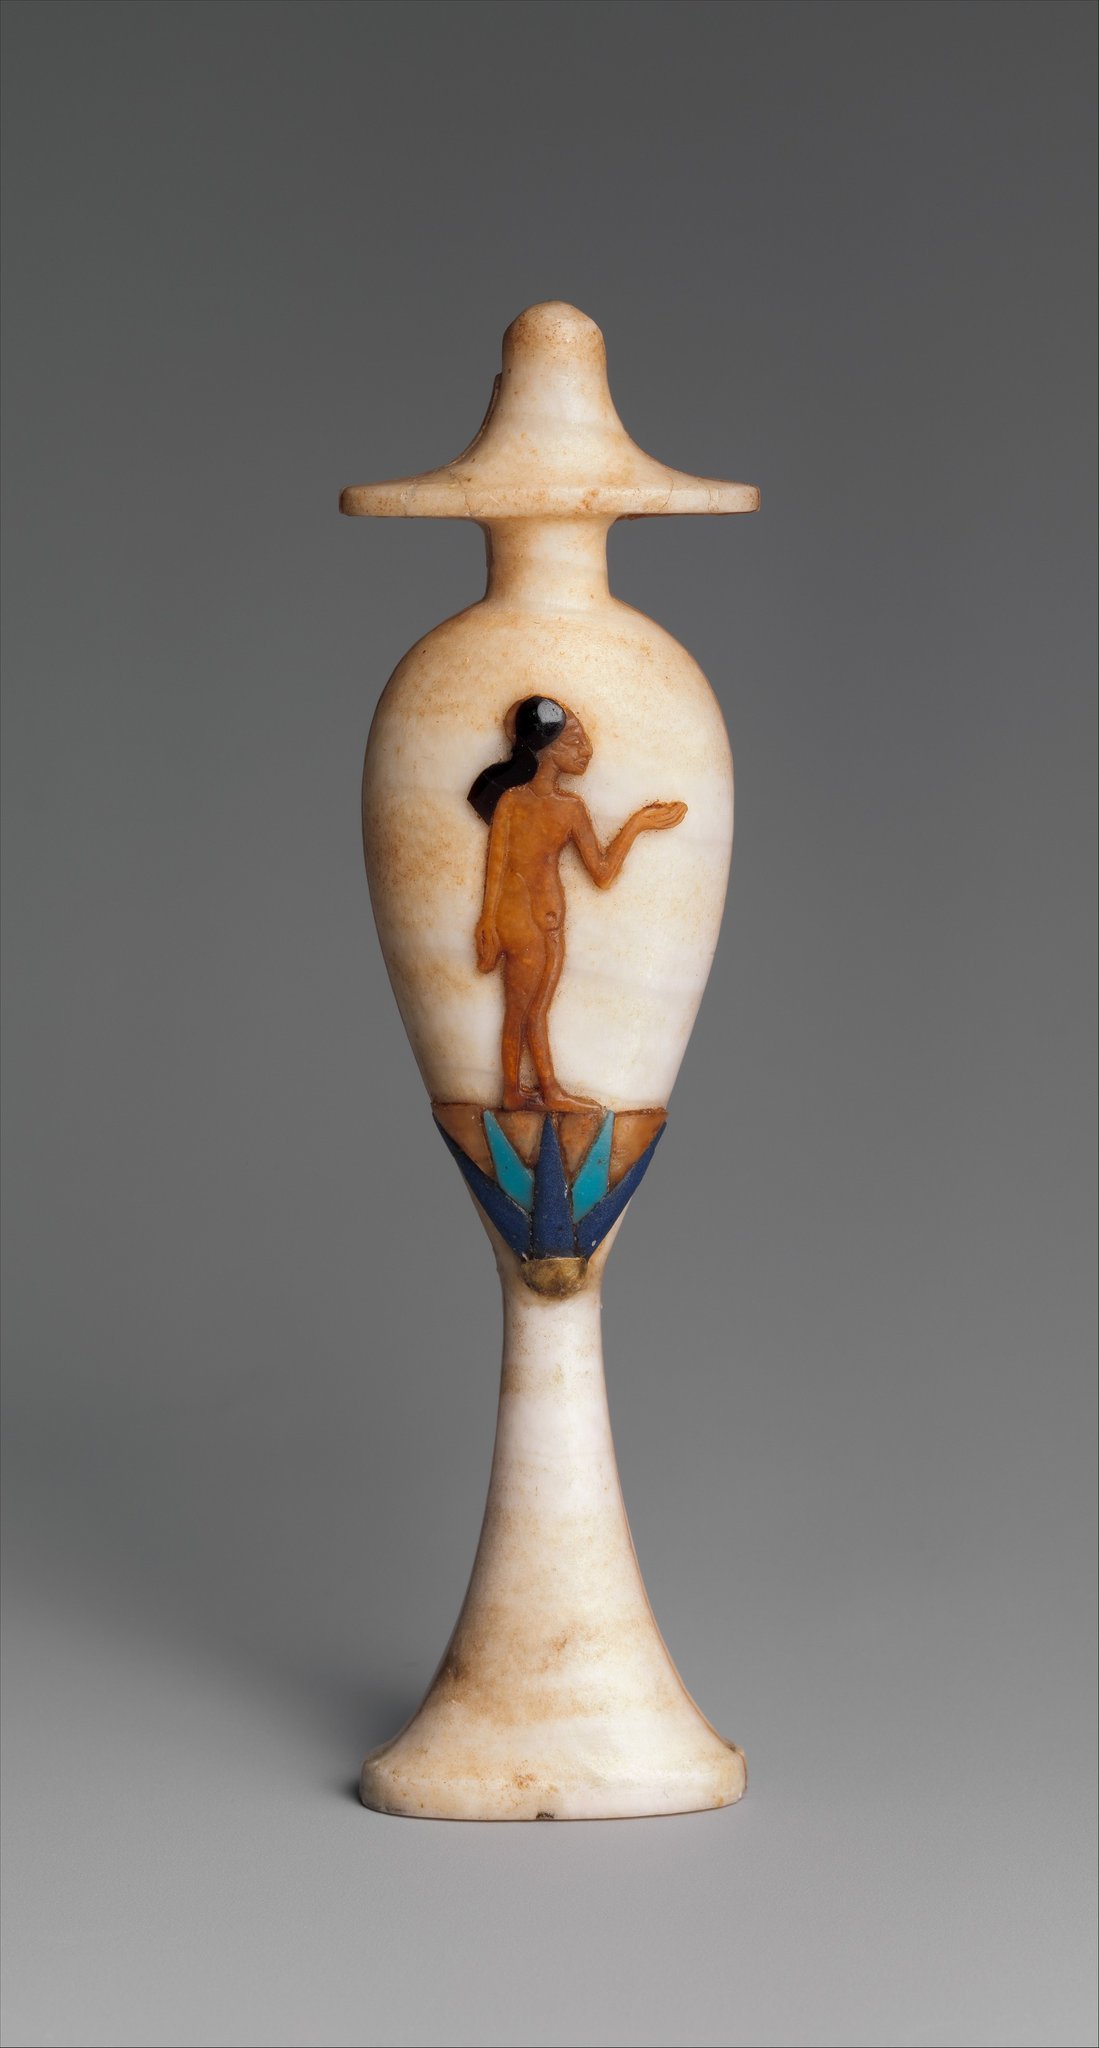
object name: small bottle in the shape of a he vase, figure of princess on lotus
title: Perfume bottle in the shape of a hes-vase inlaid with the figure of a princess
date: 1353-1336 BCE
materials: gemstone, glass, gold, obsidian, stone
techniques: inlay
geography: upper egypt, thebes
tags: princesses,women